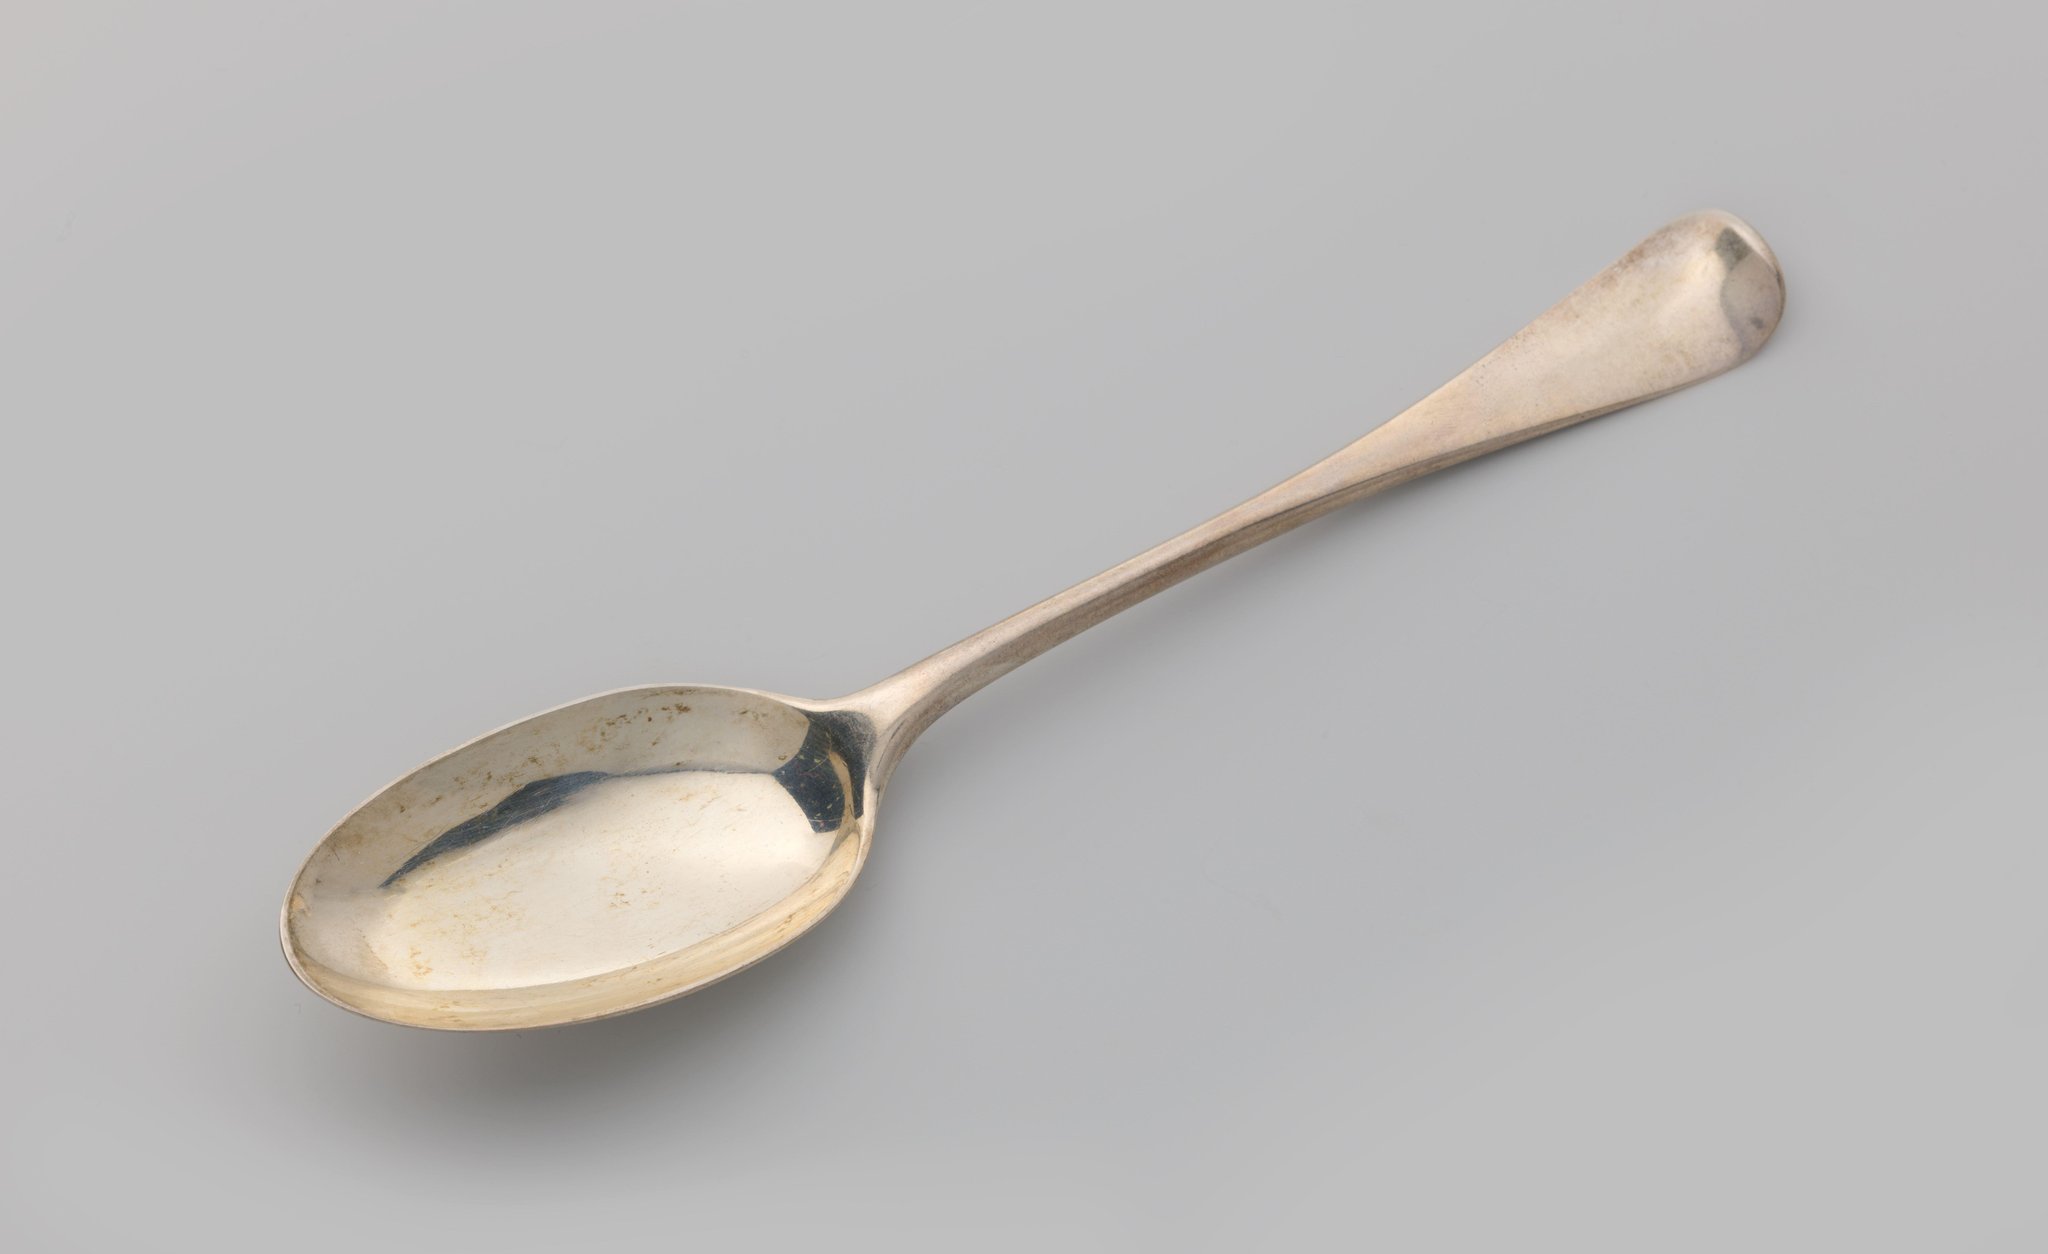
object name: spoon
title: Lepel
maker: dirk van gameren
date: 1764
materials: silver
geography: utrecht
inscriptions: mark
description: Lepel van zilver, met een ovale bak. De platte, gebogen steel verbreedt zich naar het afgeronde uiteinde.